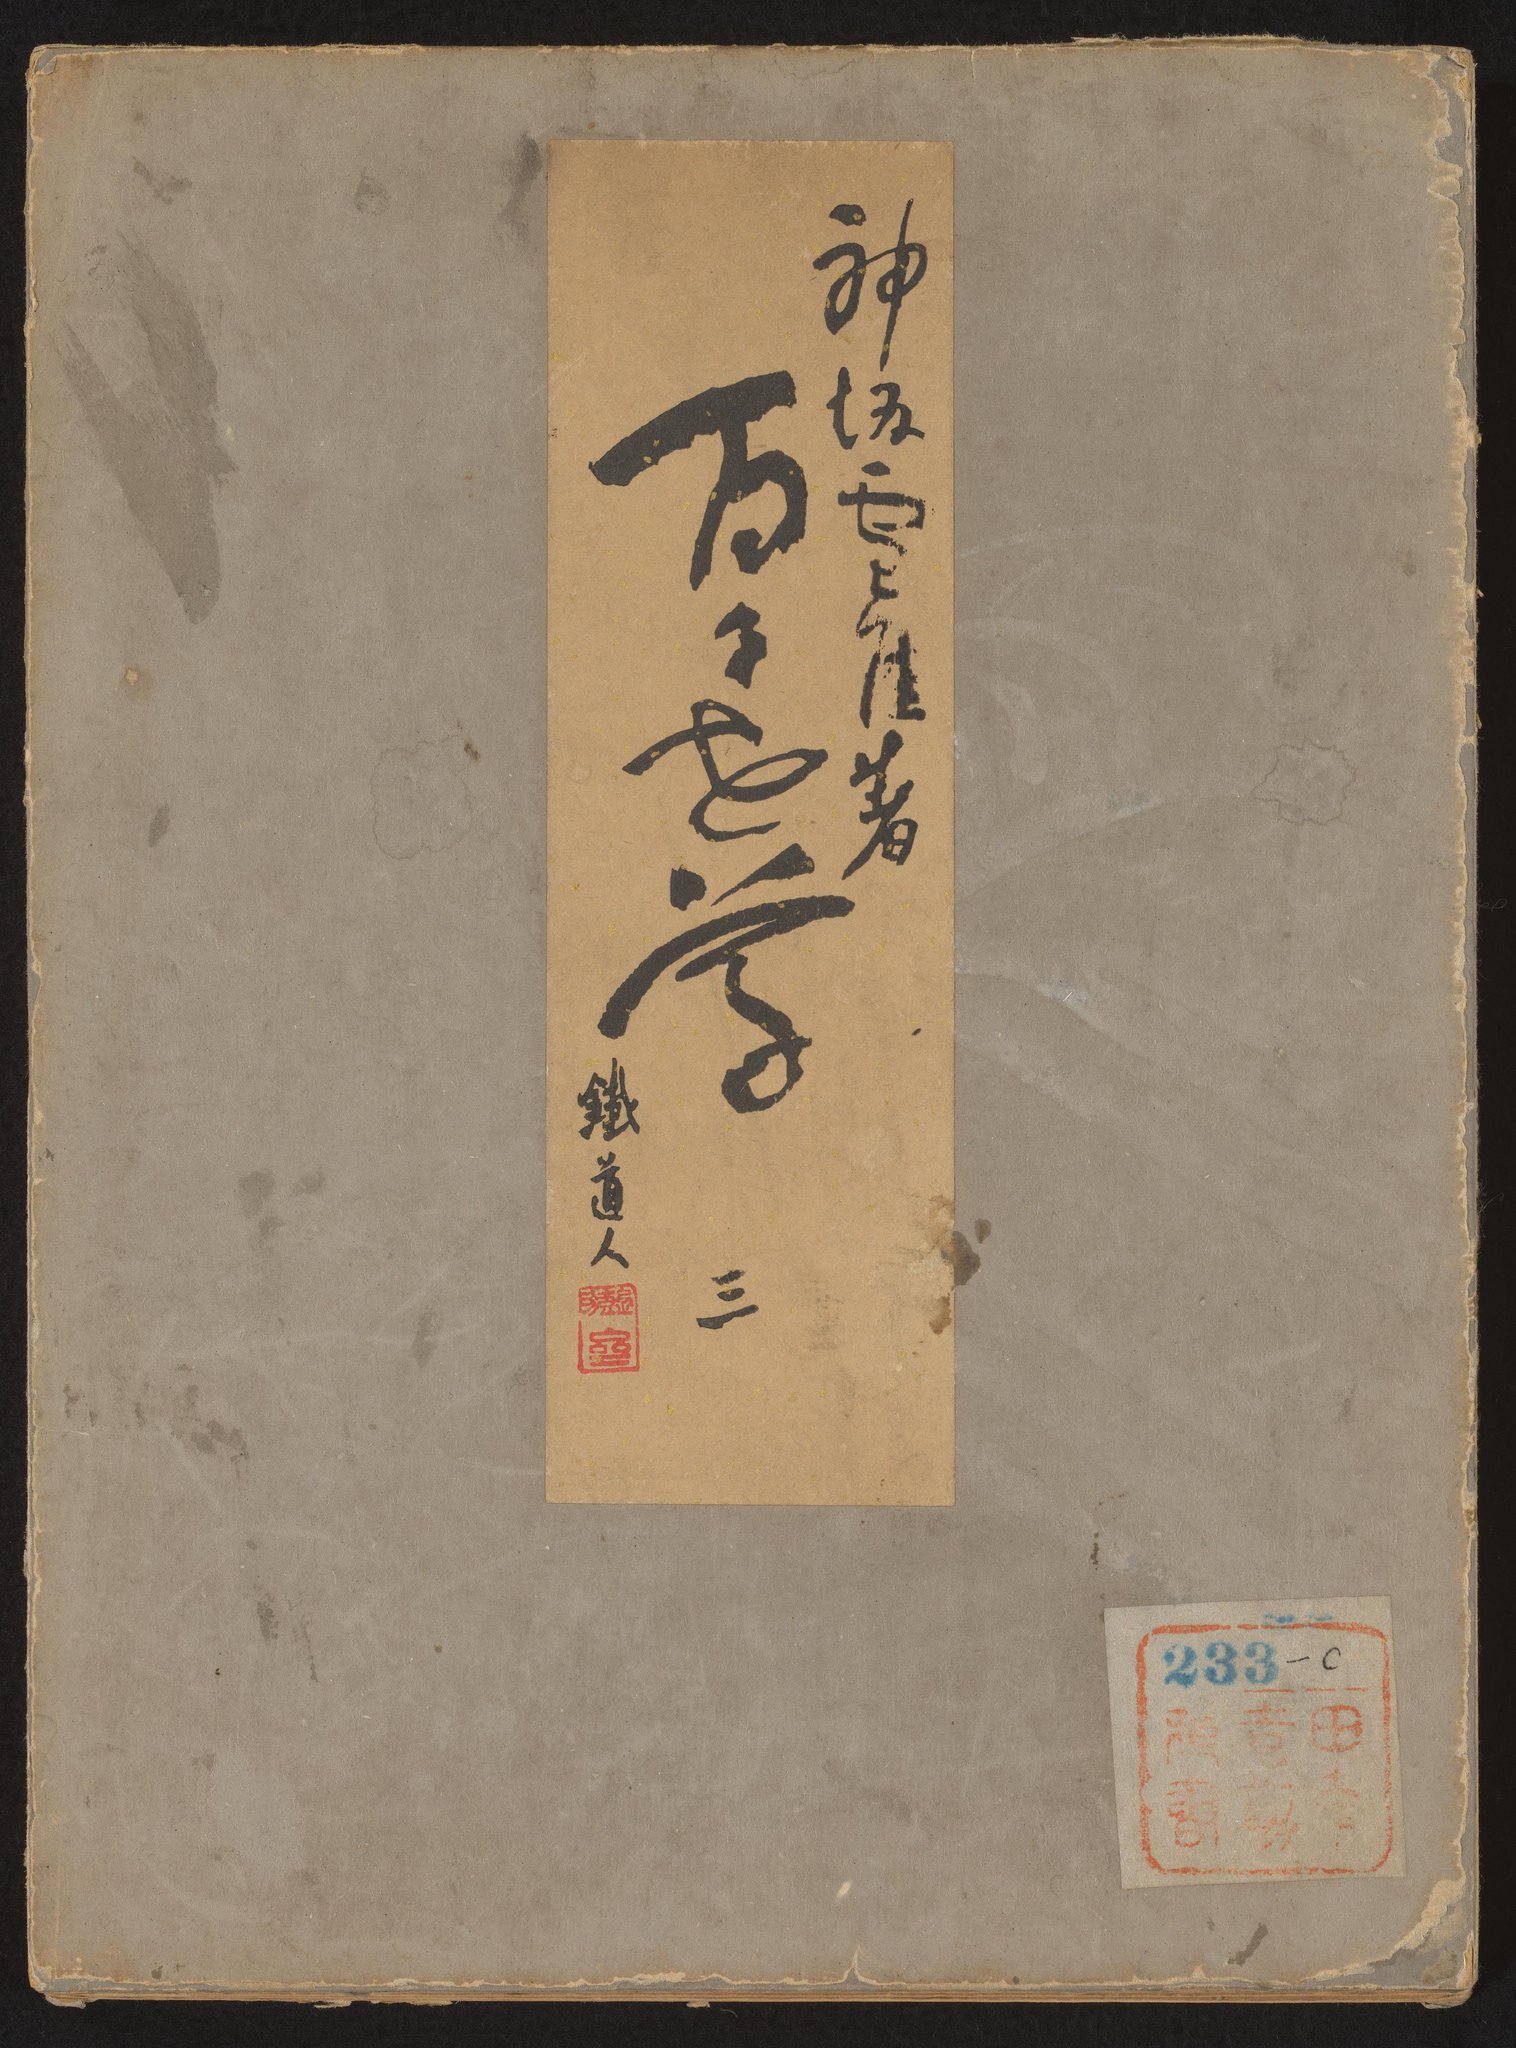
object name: prentrecueil, prentenalbum, prentalbum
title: Bloemen van honderd werelden - deel drie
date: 1910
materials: gold powder, paper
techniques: woodcut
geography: japan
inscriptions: collector's mark: Lugt 2228